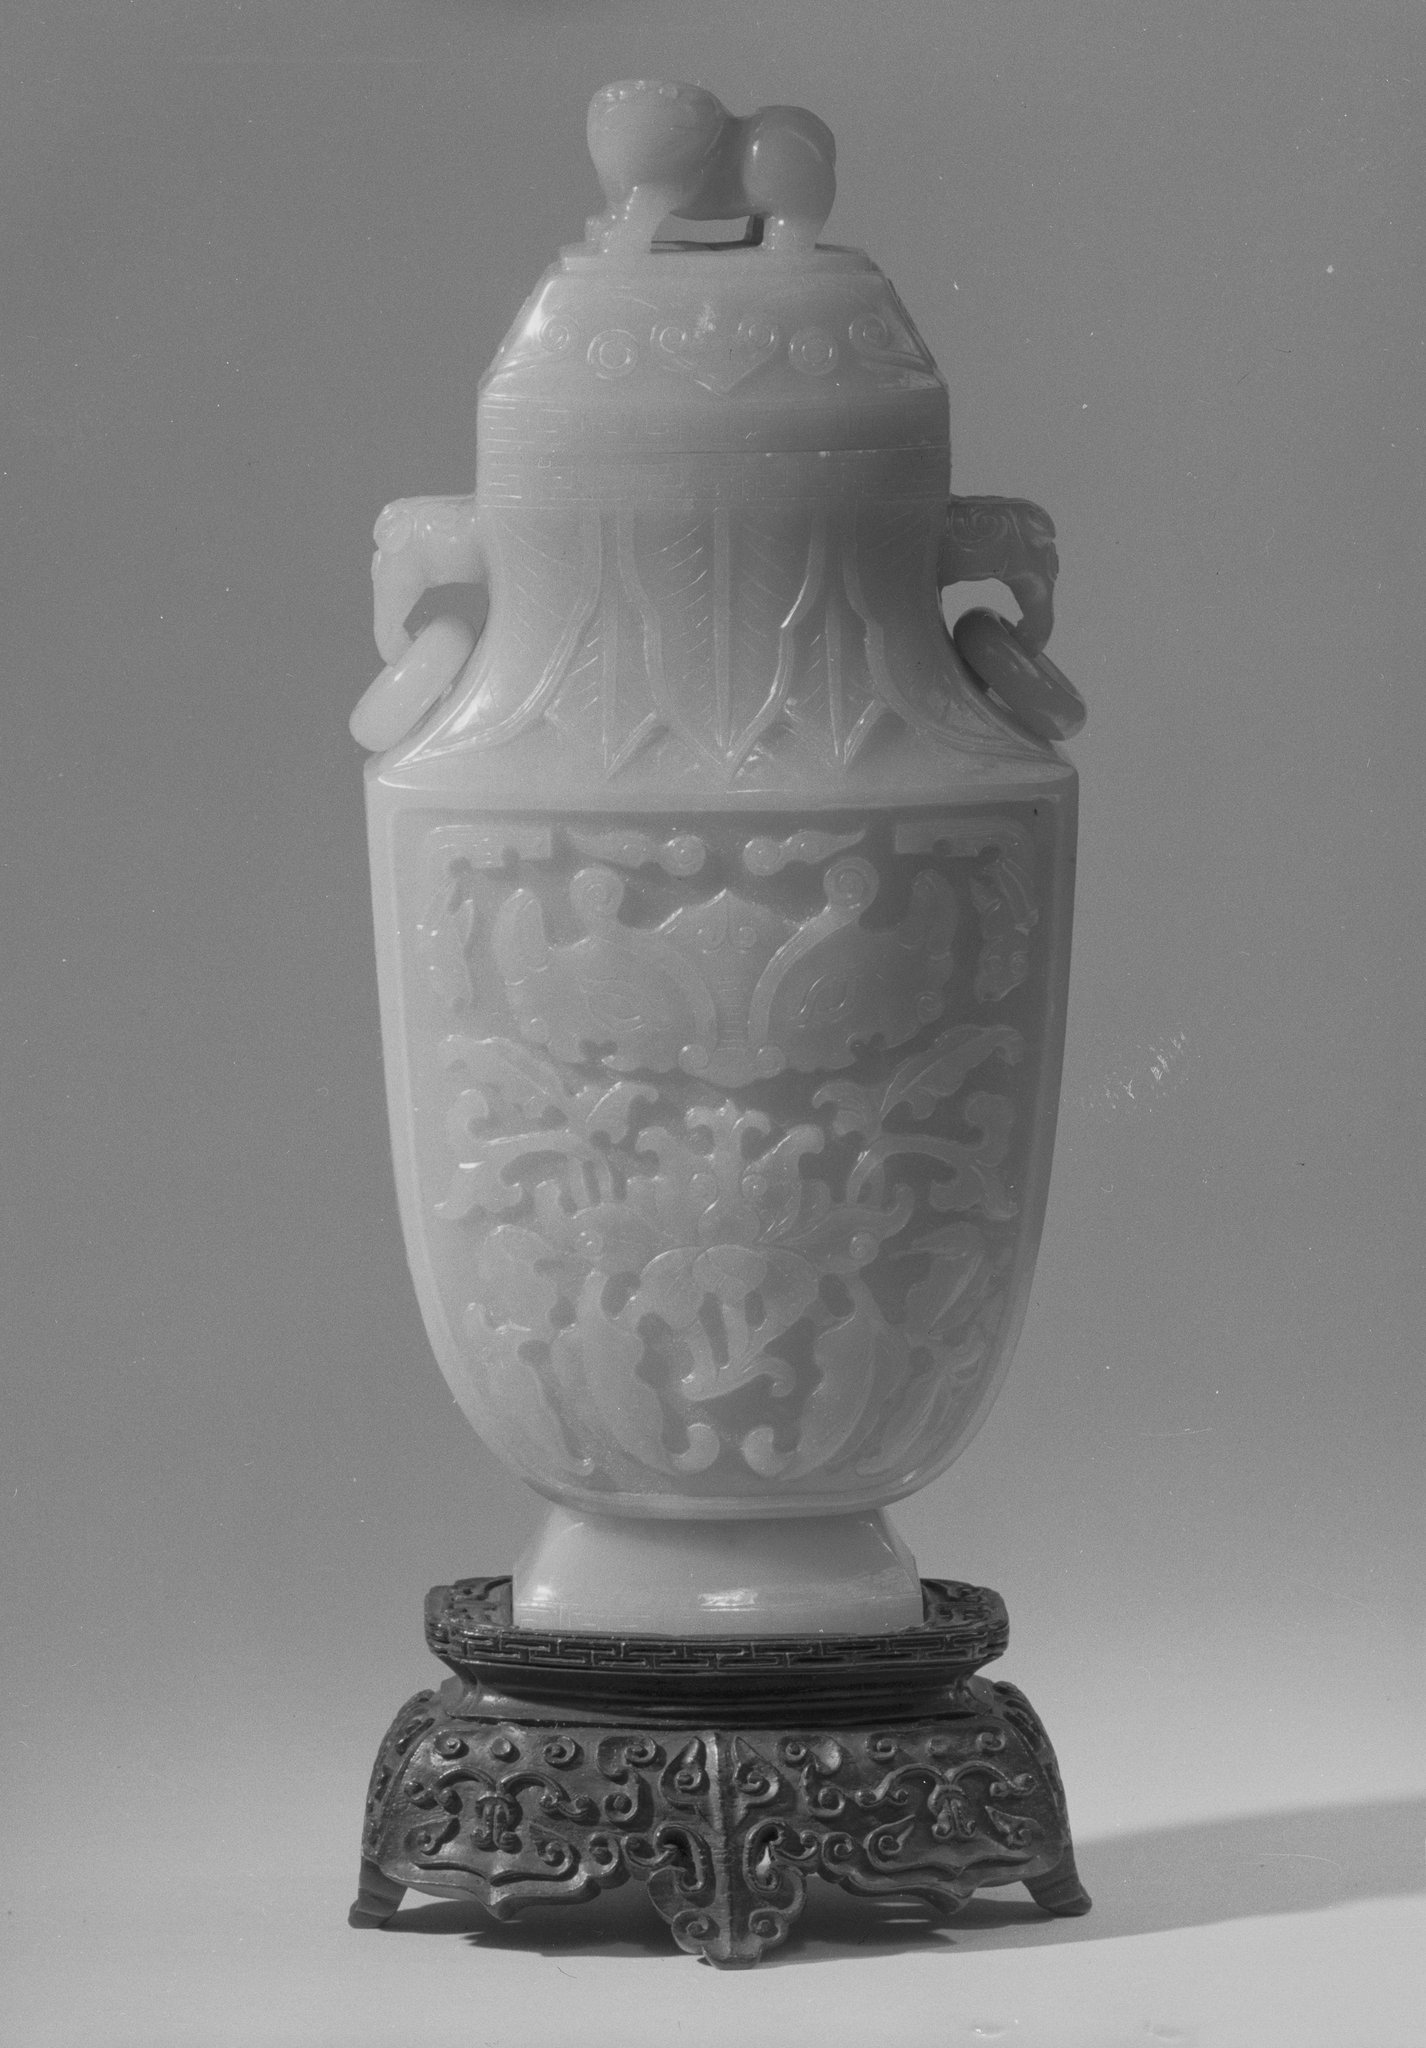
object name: covered vase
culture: chinese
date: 1801-1833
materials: jade